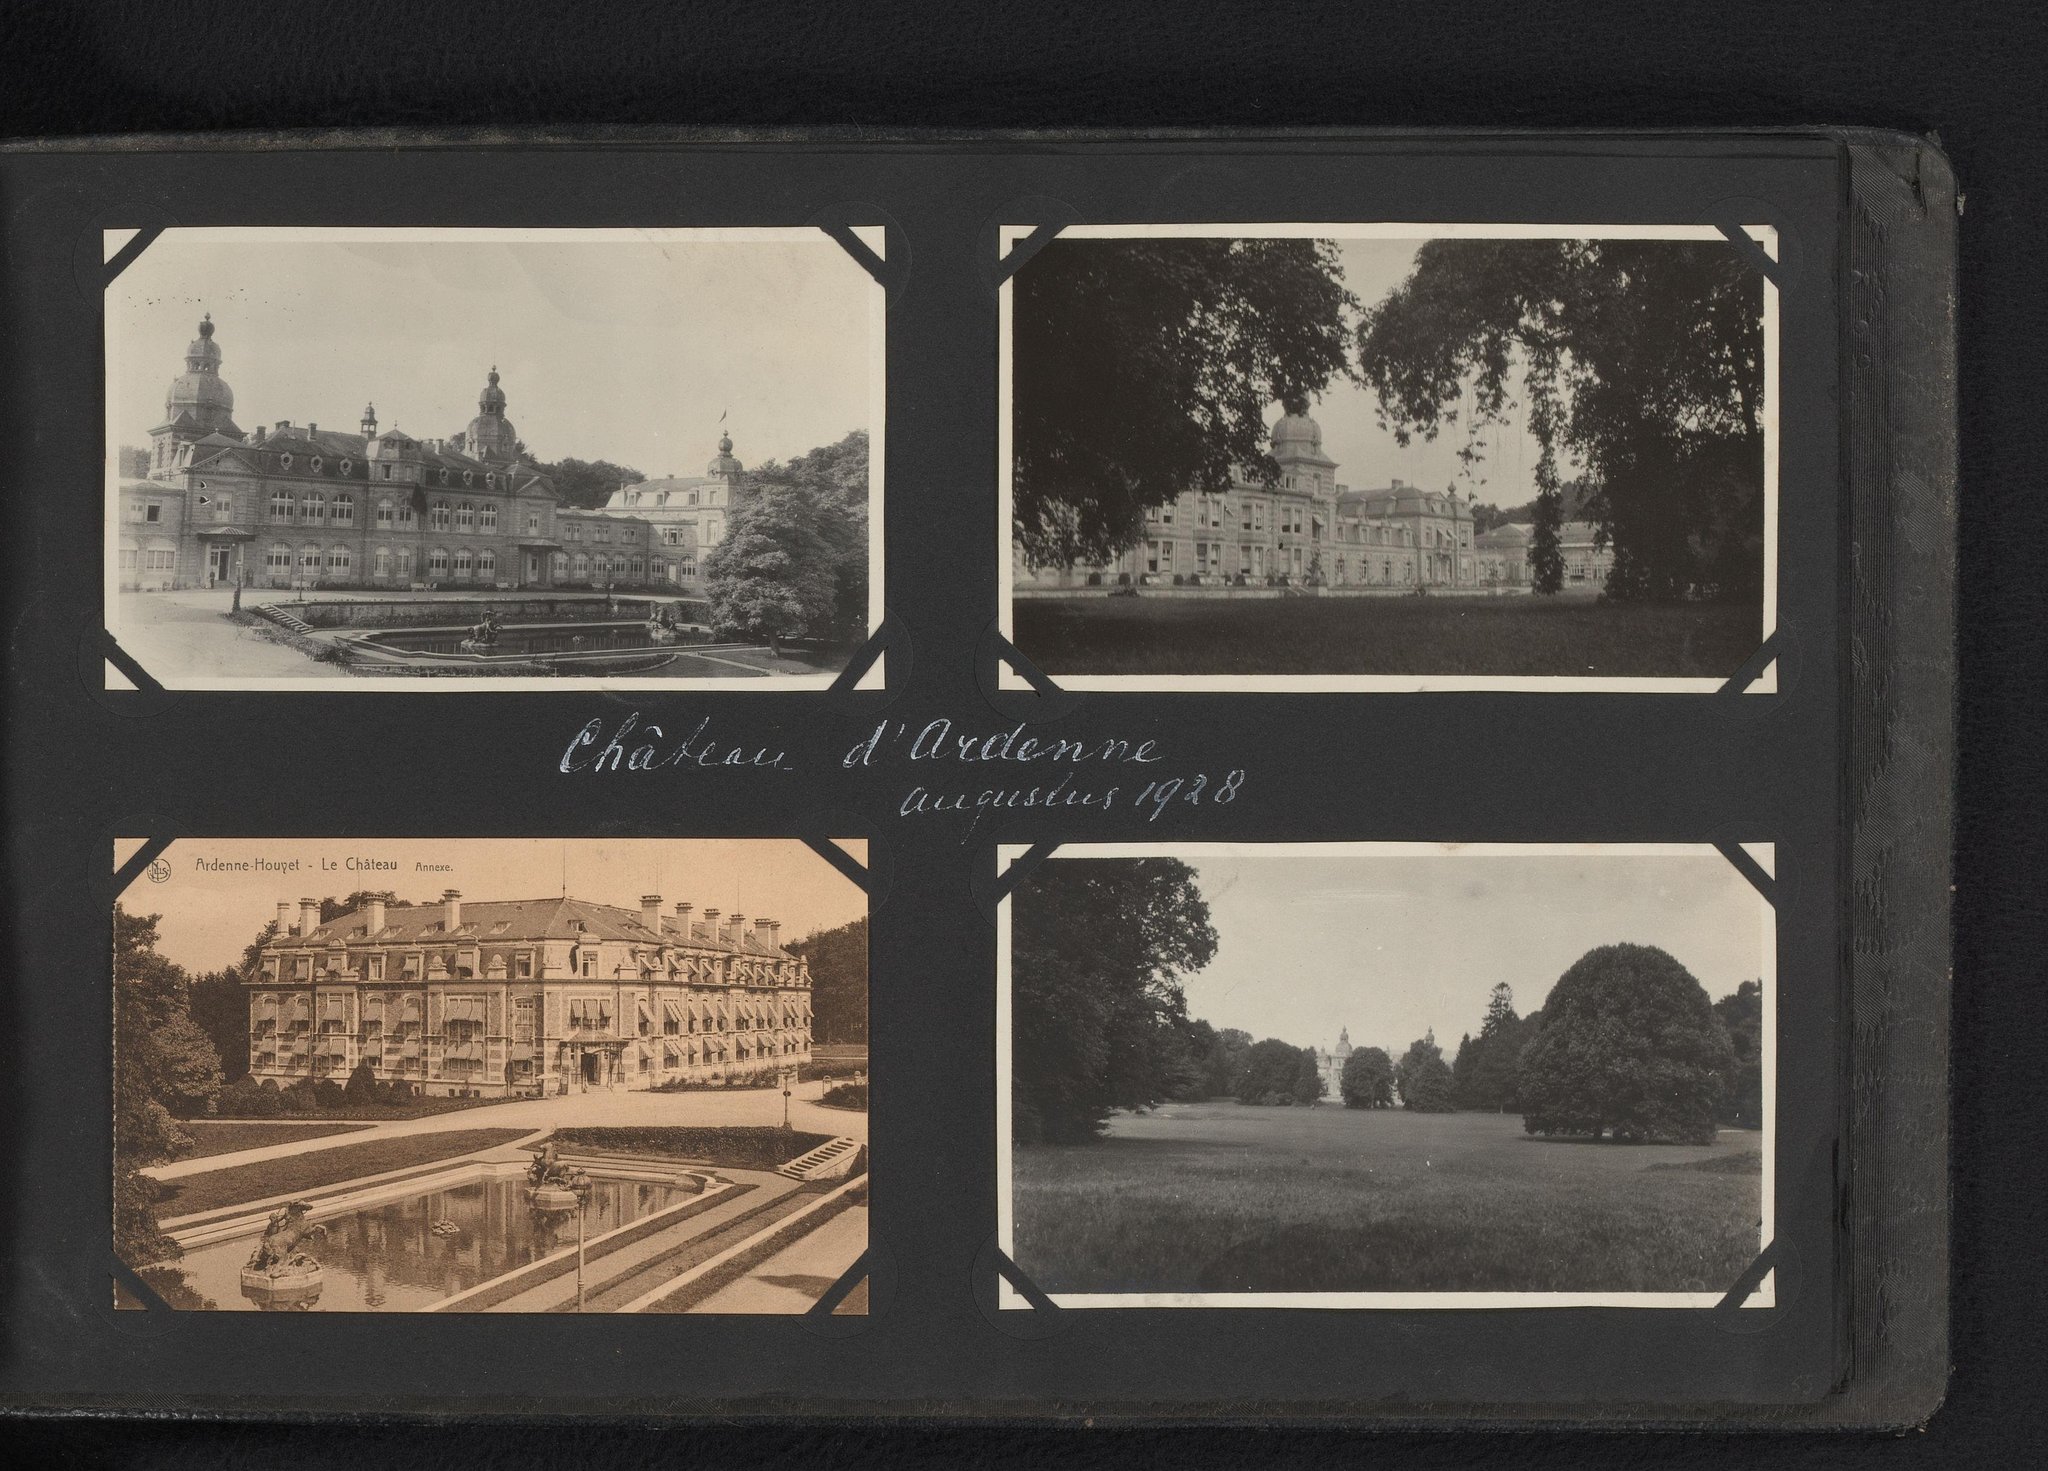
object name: album leaf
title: Drie foto's en een fotomechanische prentbriefkaart van het Château Royal d'Ardenne in Houyet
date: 1908-1928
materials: paper, cardboard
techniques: photograph, gelatin silver print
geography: brussels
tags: palace, hotel, hostelry, inn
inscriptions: inscription: ‘Ardenne-Houyet - Le Château Annexe’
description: Deze foto's en prent maken deel uit van een album.